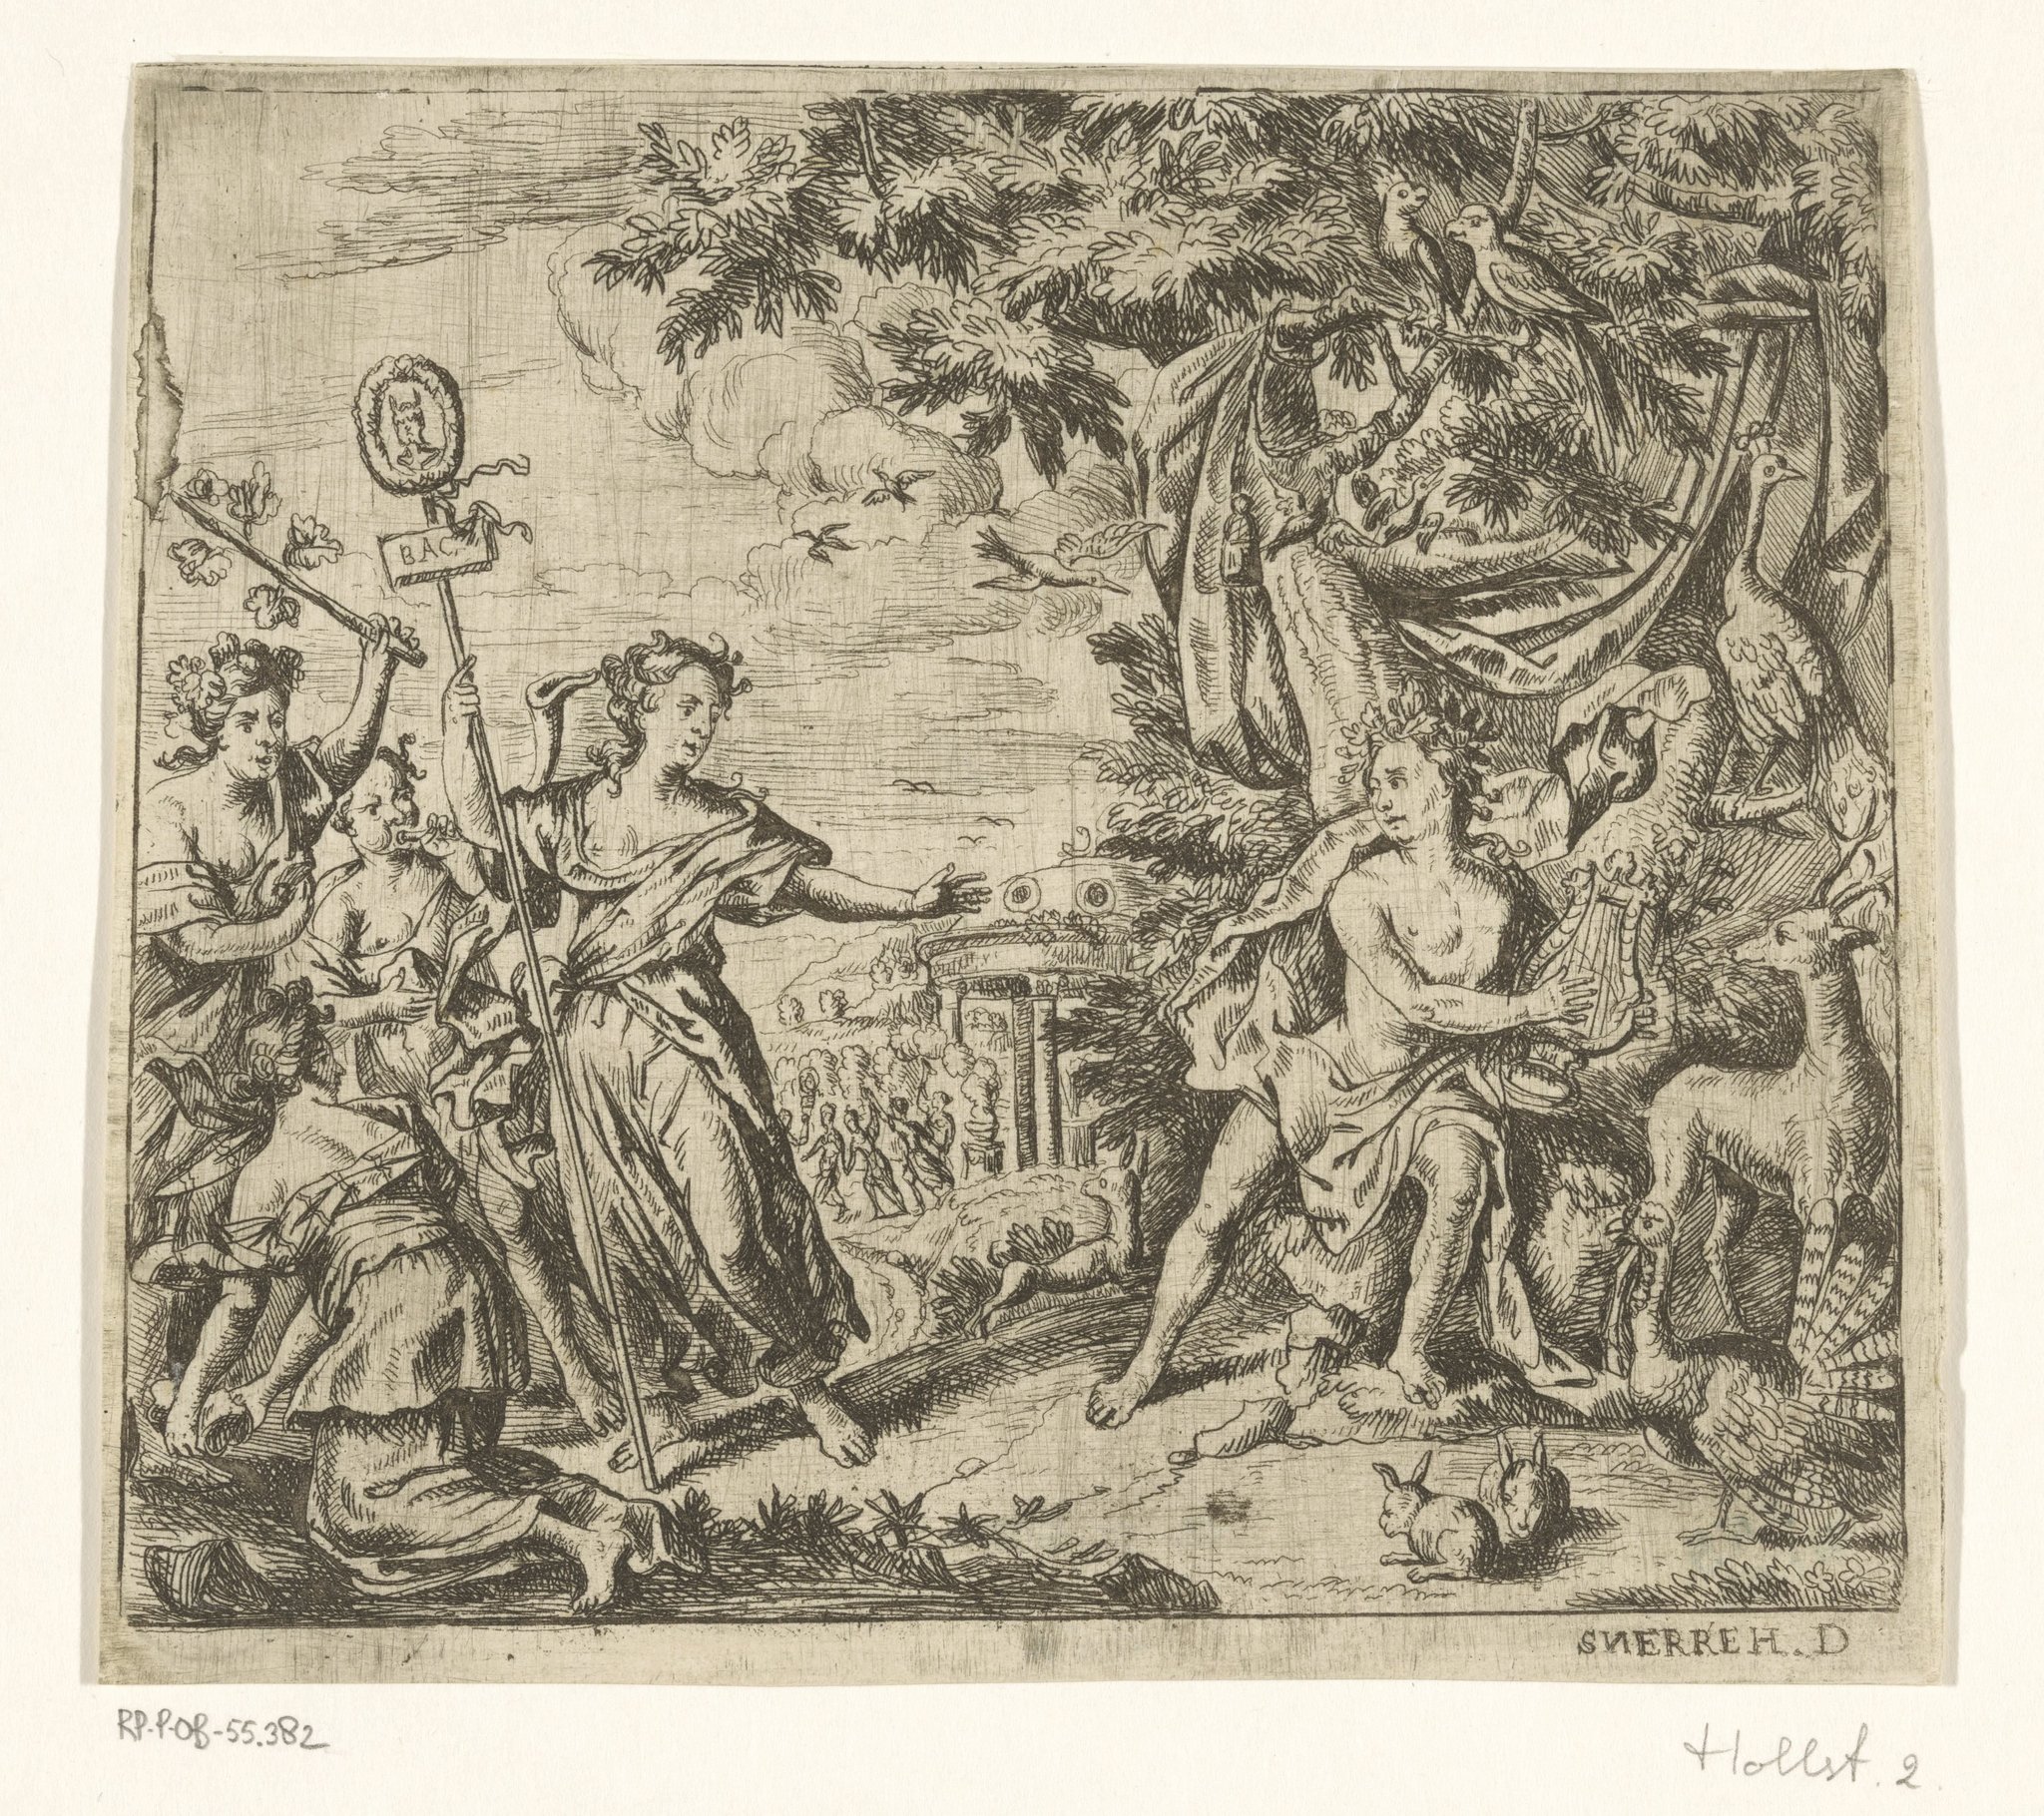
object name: print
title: Orpheus en de maenaden van Ciconia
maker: daniël herreyns (i)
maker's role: print maker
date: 1600-1649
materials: paper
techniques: etching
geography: antwerp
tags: orpheus playing the lyre, (story of) orpheus, death of orpheus: he is torn to pieces by the thracian women during a bacchic orgy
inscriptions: collector's mark: Lugt 514, collector's mark: Lugt 2165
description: Orpheus spelend op zijn lier en omringd door dieren ontmoet de razende maenaden van Ciconia in Thracië die hem zullen aanvallen en verscheuren, omdat hij geen aandacht heeft voor vrouwen na de dood van zijn geliefde Eurydice. Op de achtergrond meer aanbidsters van Bacchus die uit een tempel komen.